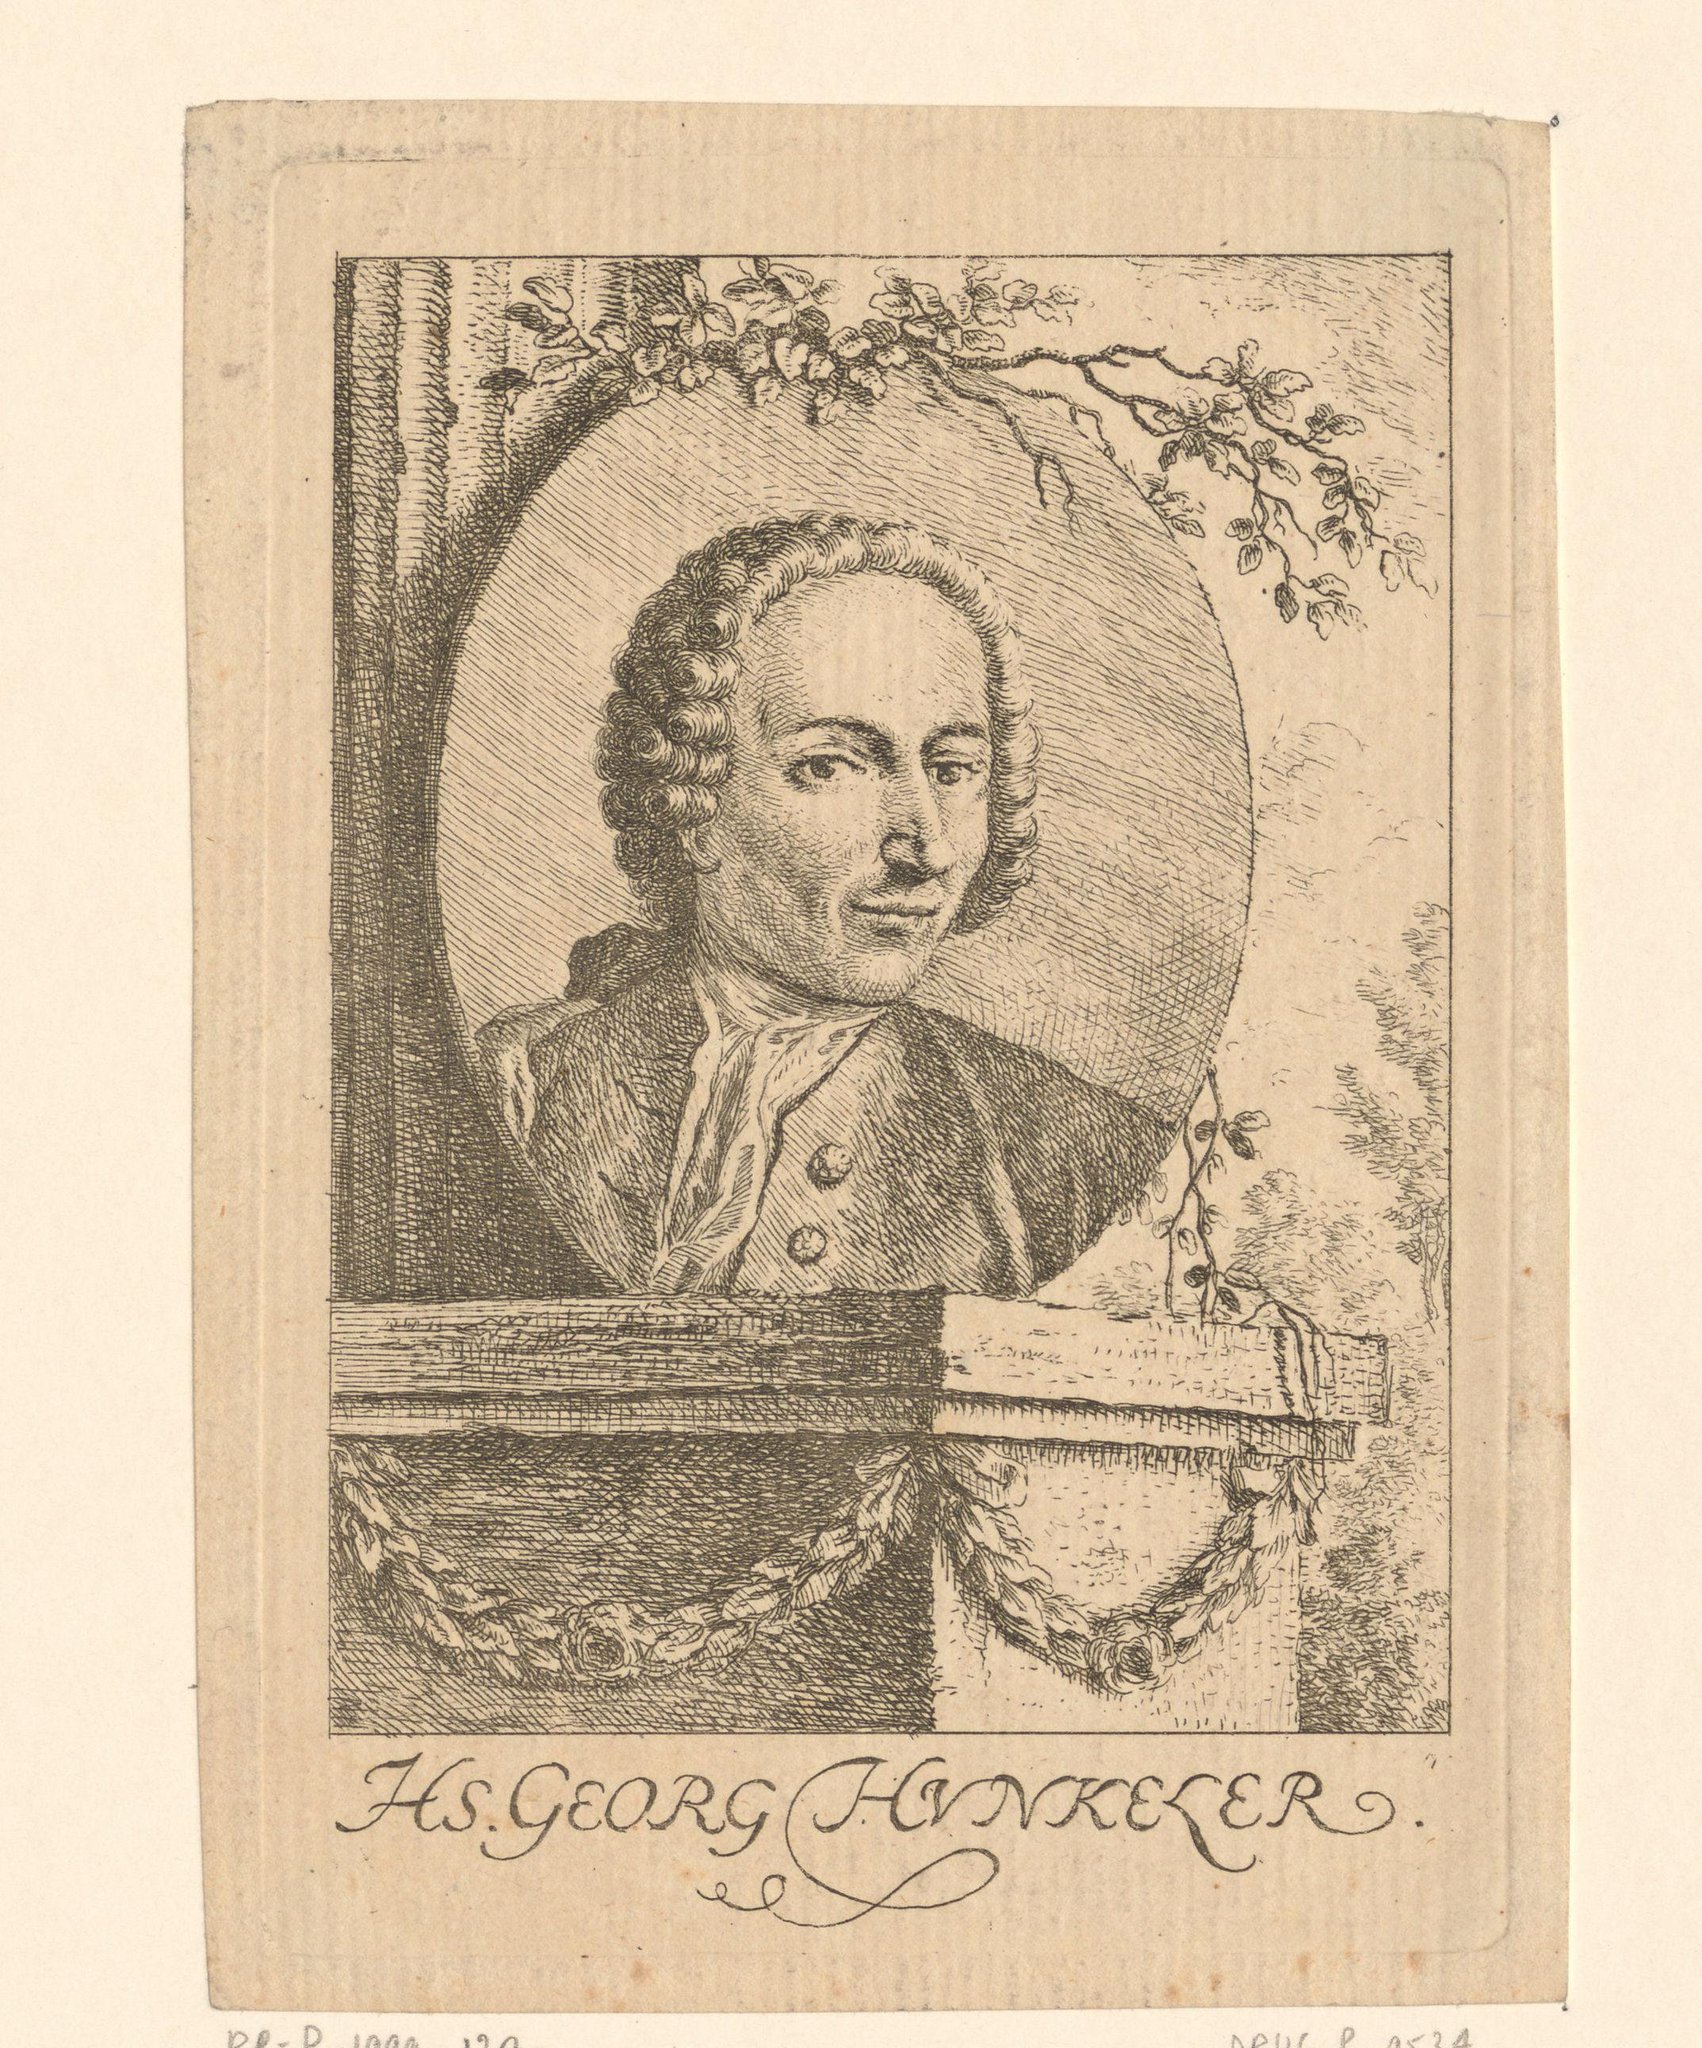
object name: print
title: Portret van Hans Georg Hunkeler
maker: rudolf füssli (der jüngste)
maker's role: print maker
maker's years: 1737-1806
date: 1755-1757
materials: paper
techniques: etching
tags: painter, historical persons, portrait, self-portrait of painter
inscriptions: collector's mark: Lugt 2228, collector's mark: Lugt 2760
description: Prent gebruikt in: Füssli, Johann Caspar. Geschichte Und Abbildung der besten Mahler in der Schweitz. Zürich: David Gessner, 1755-1757.